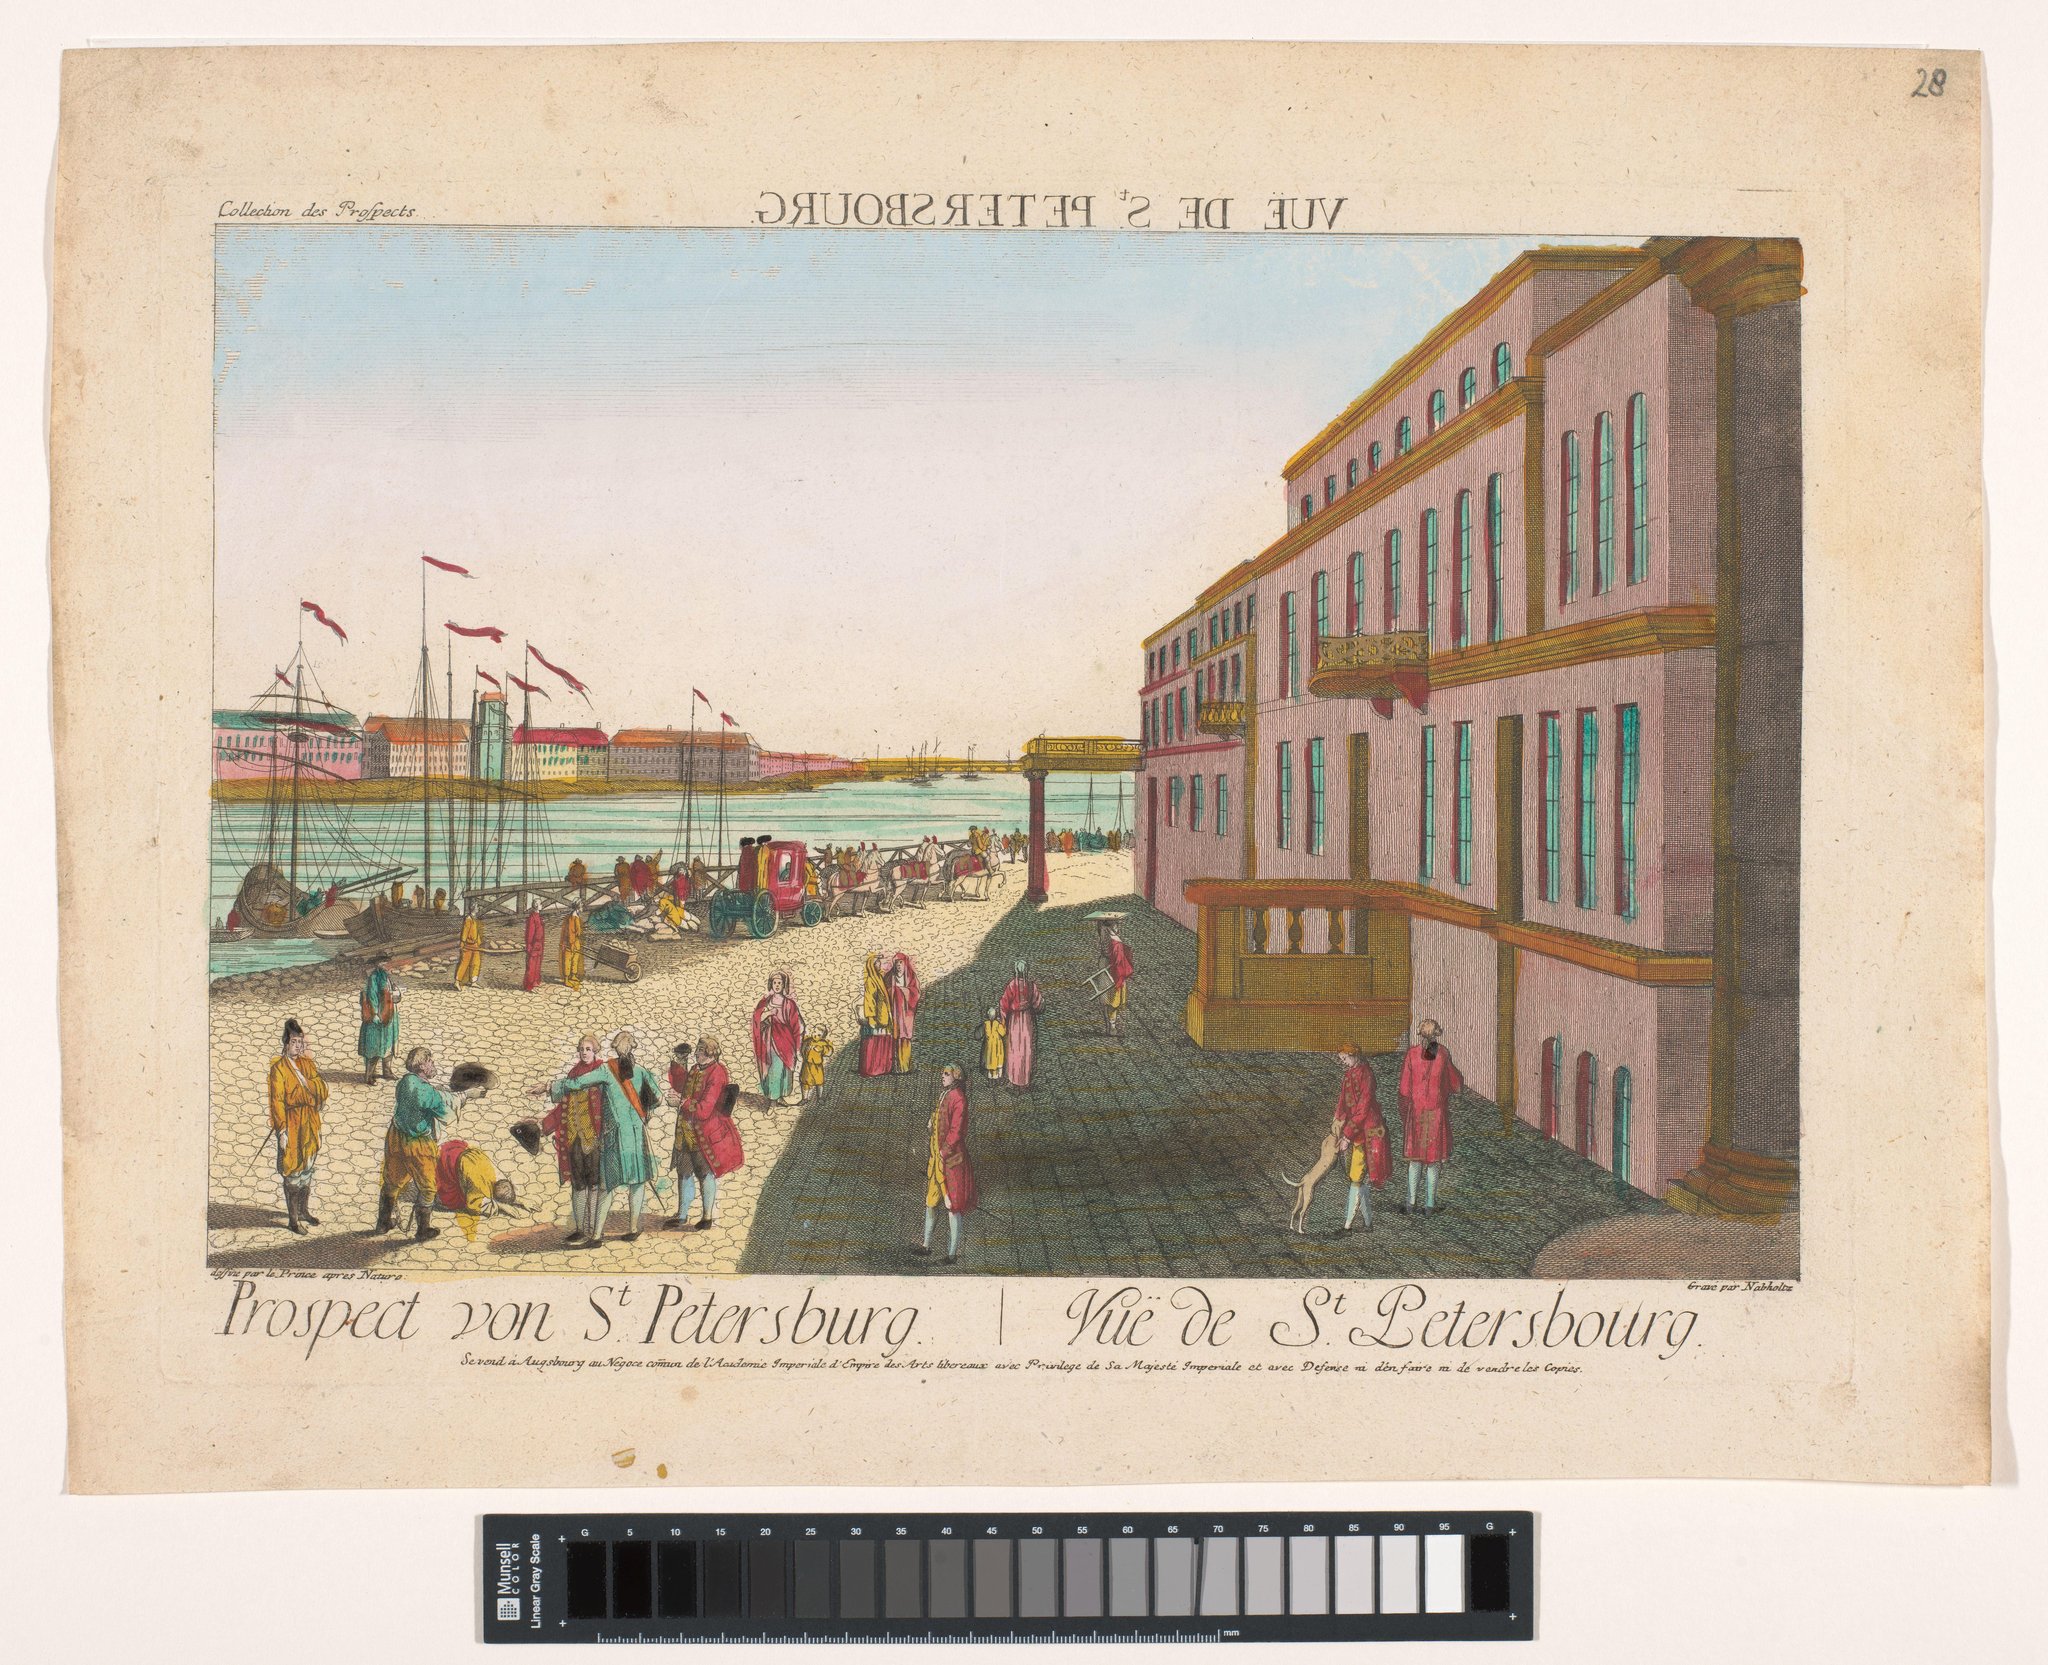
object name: opticaprent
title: Gezicht op de stad Sint-Petersburg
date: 1755-1779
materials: paper, watercolor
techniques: brush, etching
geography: germany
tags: sailing-ship, sailing-boat, civic architecture; edifices; dwellings, city-view in general; 'veduta' (+ city(-scape) with figures, staffage), canals, waters (in city) (+ city(-scape) with figures, staffage)